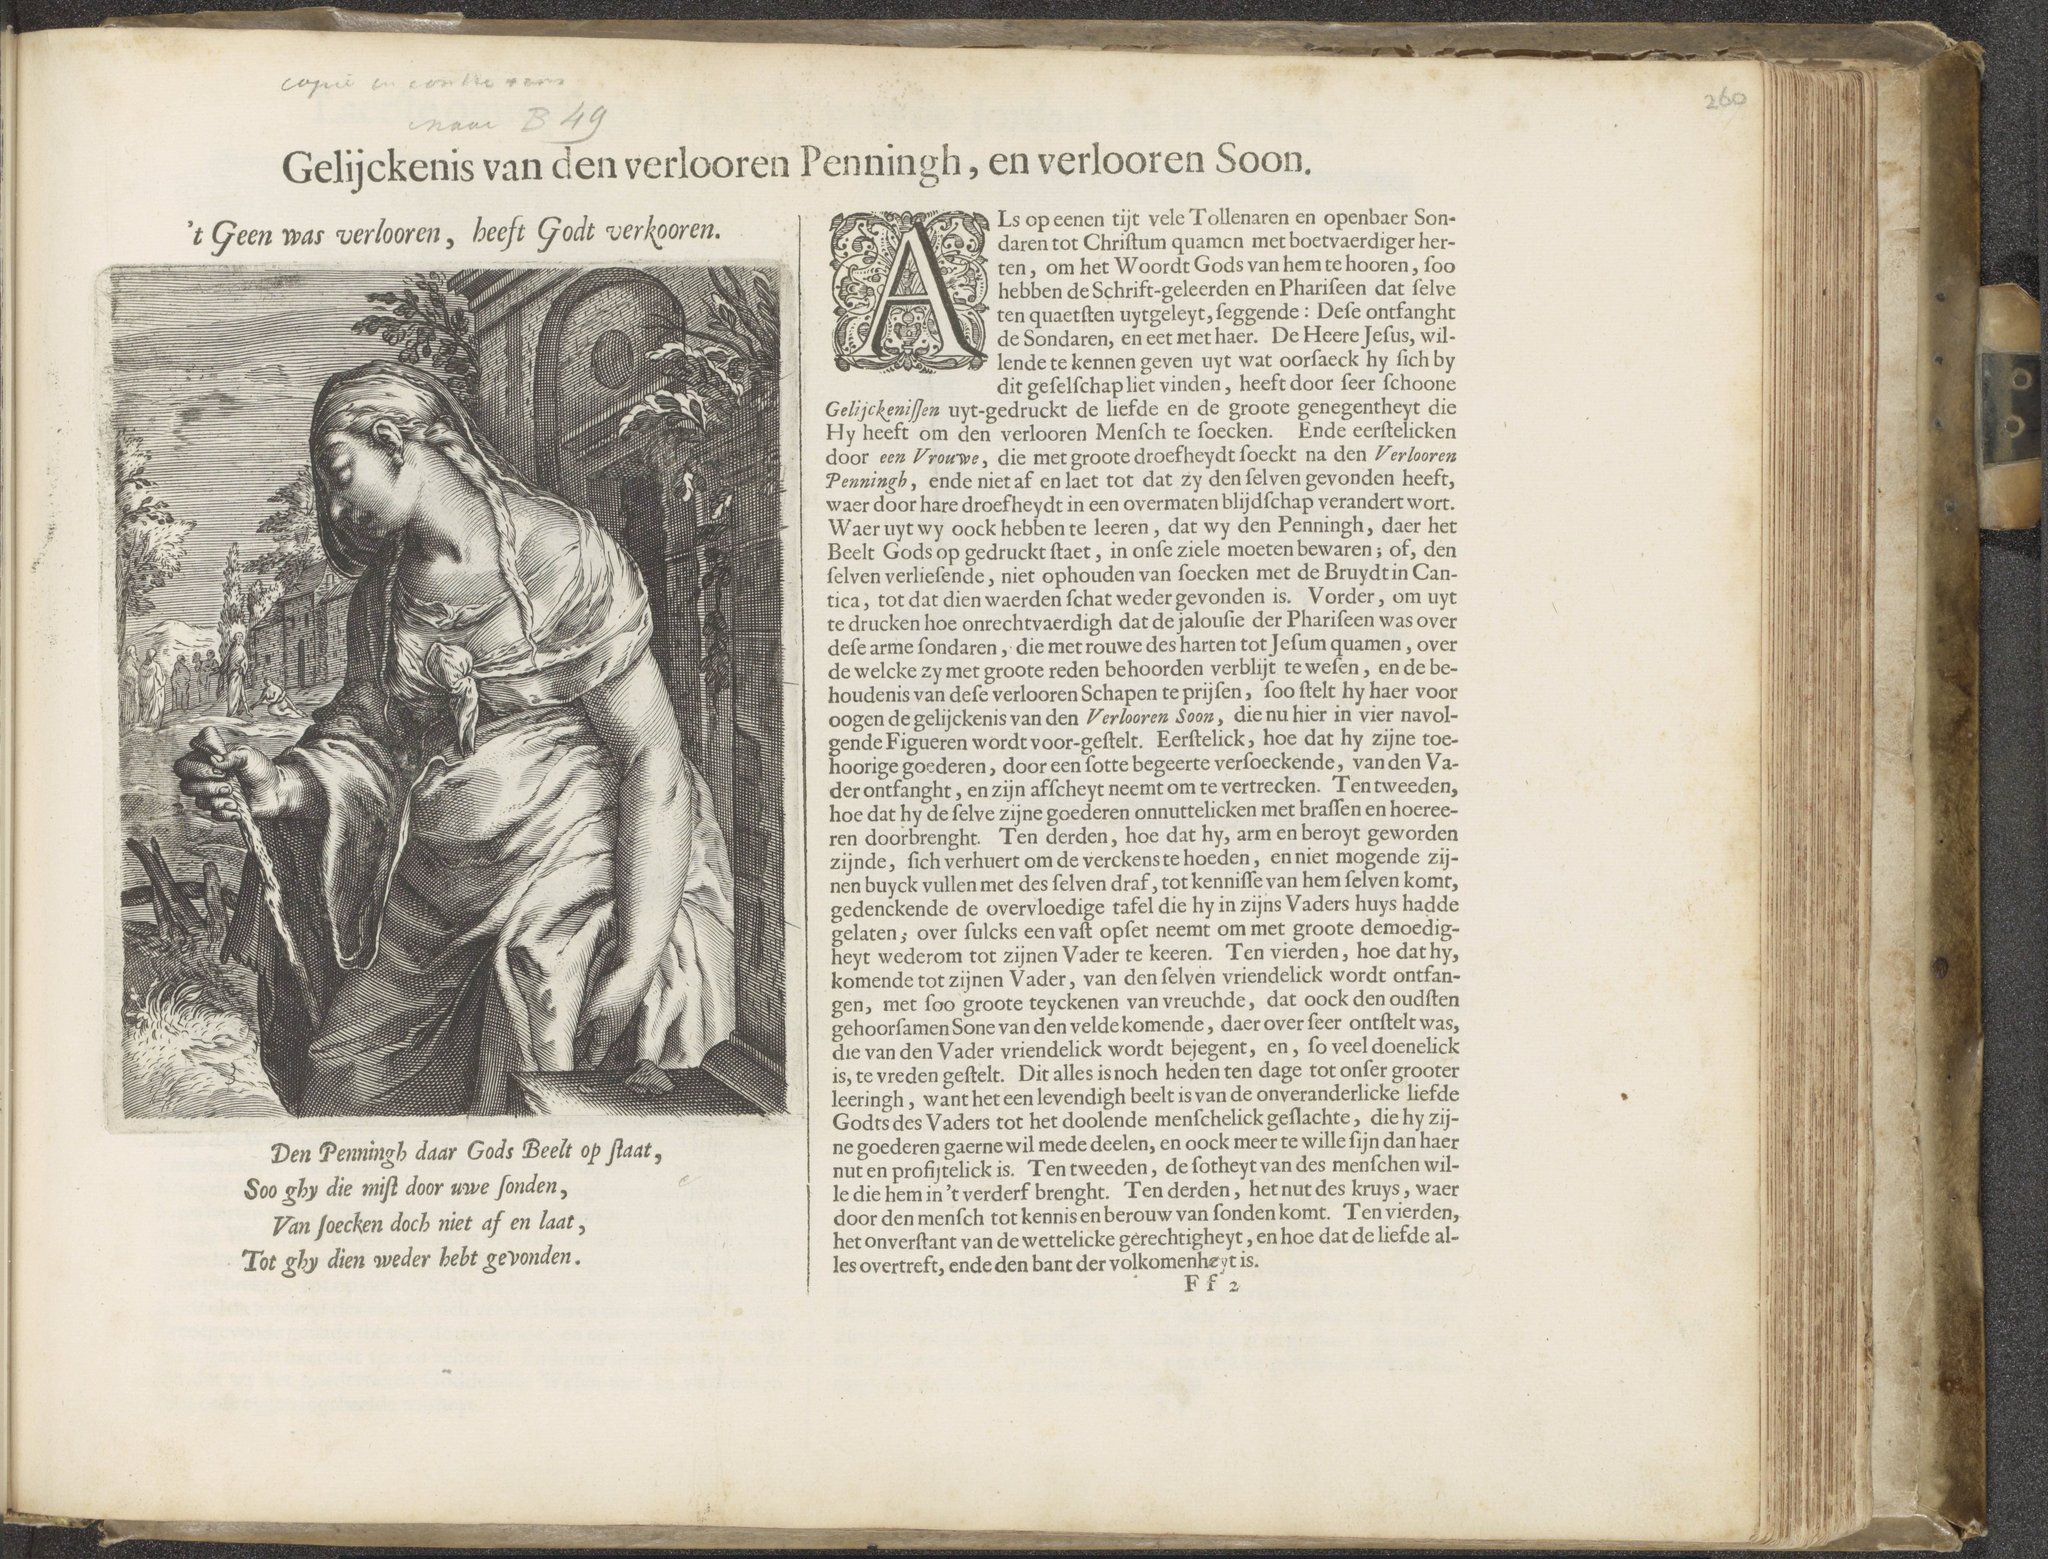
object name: album leaf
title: Bloedvloeiende vrouw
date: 1575-1650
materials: paper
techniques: engraving, letterpress printing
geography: amsterdam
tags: parables and proverbial sayings of christ ~ human and divine love, healing of a woman with an issue of blood: she kneels before christ after having touched his robe (matthew 9:20-22; mark 5:25-34; luke 8:43-48), 'portraits' of christ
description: Afbeelding van de bloedvloeiende vrouw, afgebeeld met wandelstok, in dit album gebruikt als voorstelling bij de gelijkenis van de verloren penning. Een vrouw die tien drachmen heeft en er een verliest, zal blij zijn als ze na het zoeken het ene muntstuk terugvindt. Zo is er ook vreugde onder de engelen van God over een zondaar die tot inkeer komt (Luc. 15:8). De begeleidende tekst begint met een gedecoreerde initiaal A. Het blad maakt deel uit van een album.